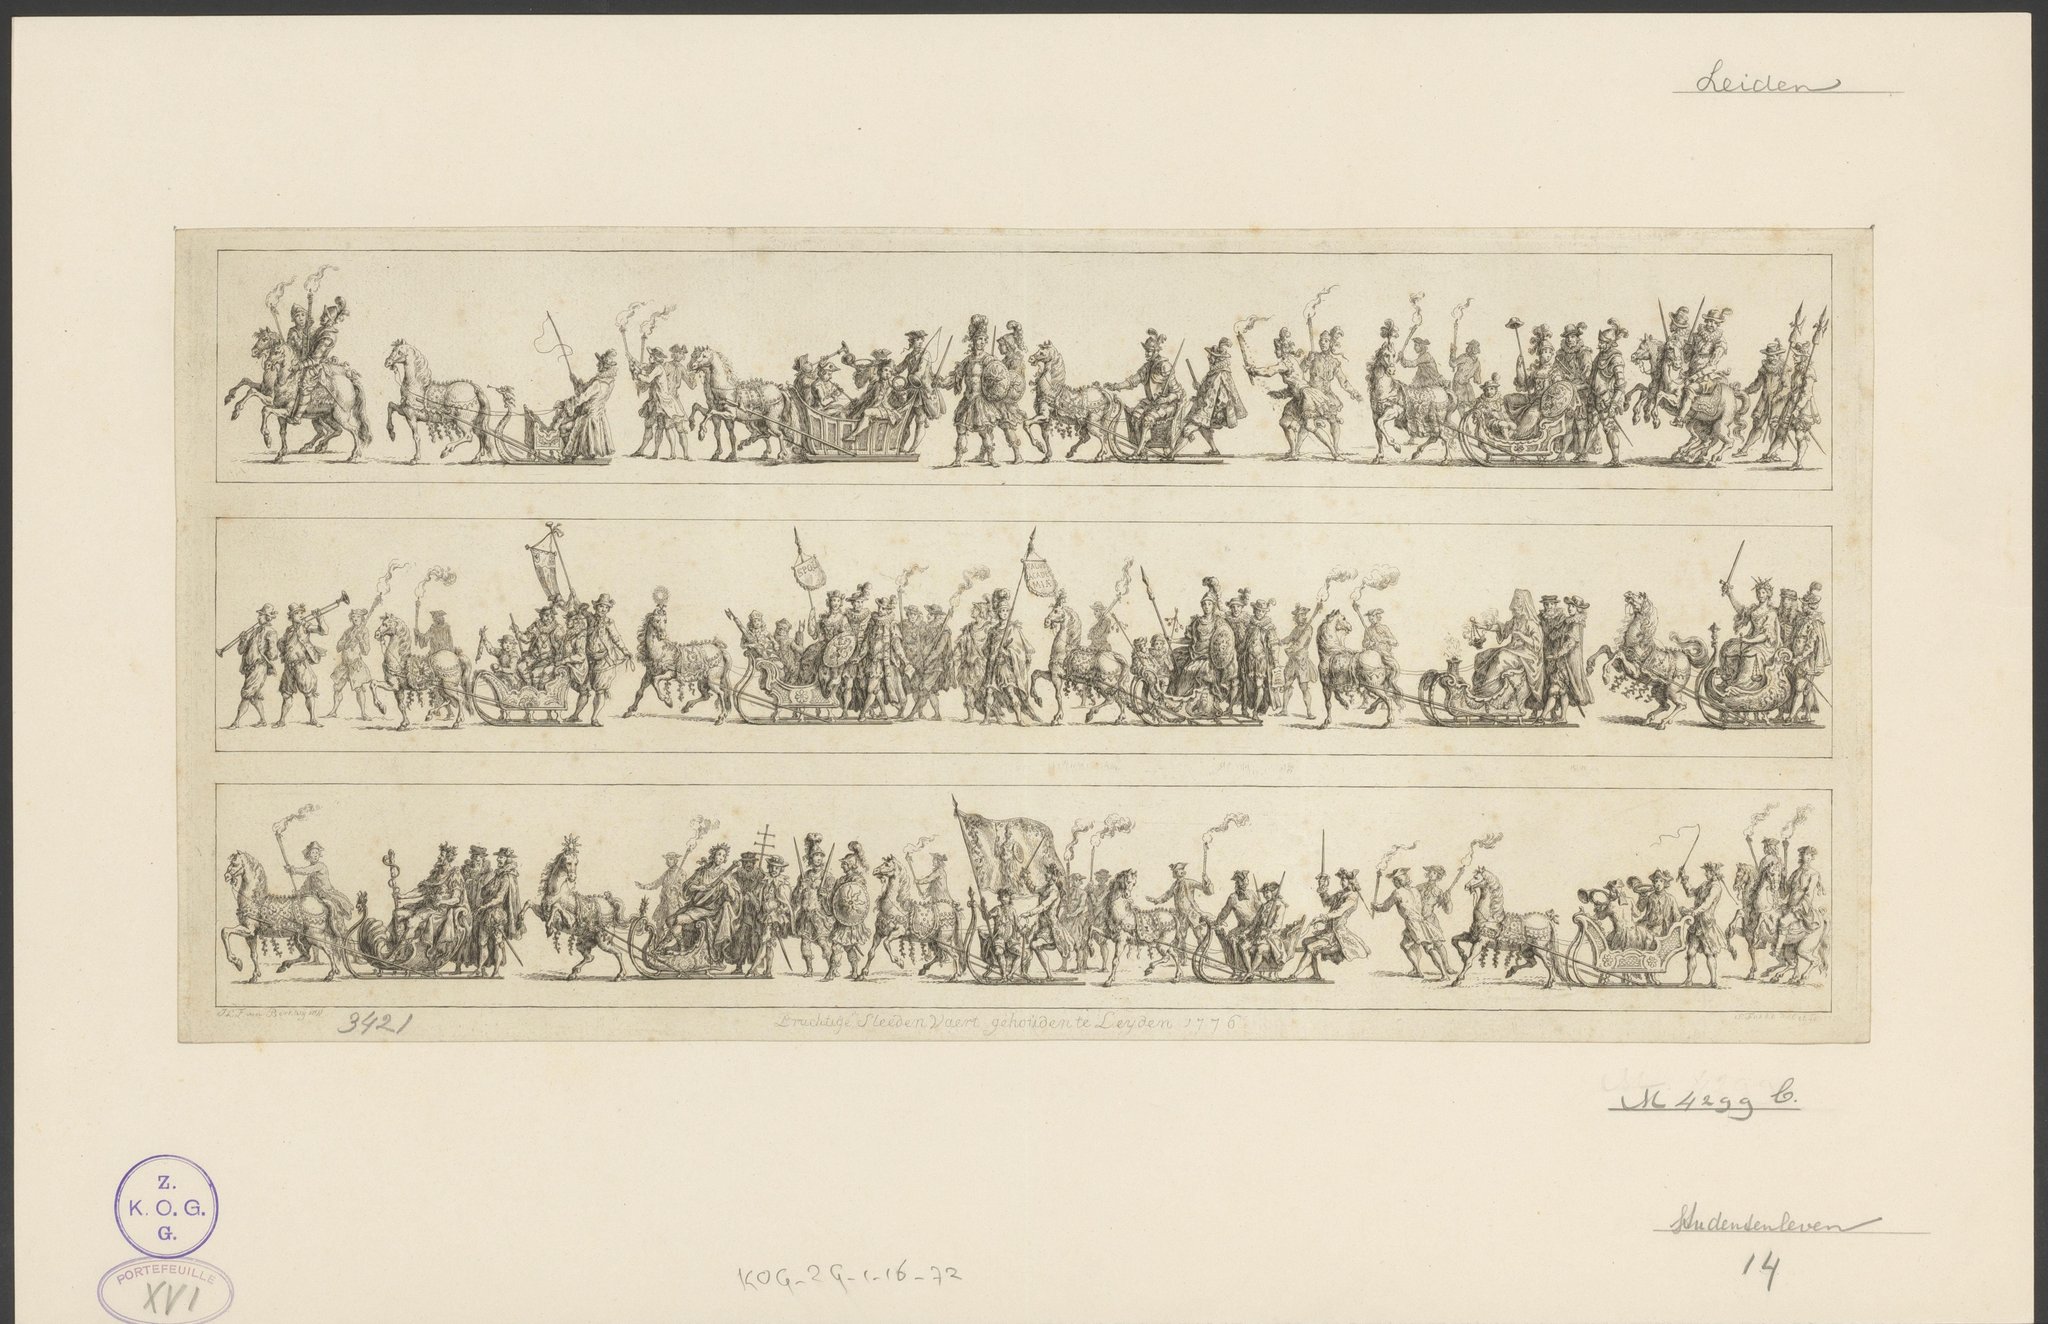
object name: print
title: Prachtige Sleeden Vaert gehouden te Leyden 1776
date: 1776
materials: paper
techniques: etching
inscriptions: stamp, collector's mark: Lugt 1641, stamp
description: De sledevaart op 24 januari 1776 georganiseerd door het Leidse genootschap Veniam Pro Laude bij gelegenheid van het Tweede Eeuwfeest van het Leids Ontzet (3 oktober 1574) en de oprichting van de Universiteit van Leiden (8 februari 1575). De veertien sleden in drie rijen onder elkaar. Onderwerpsrubrieken binnen de Atlas Zeden en Gewoonten: Onderwijs en Wetenschappen, Studentenleven.